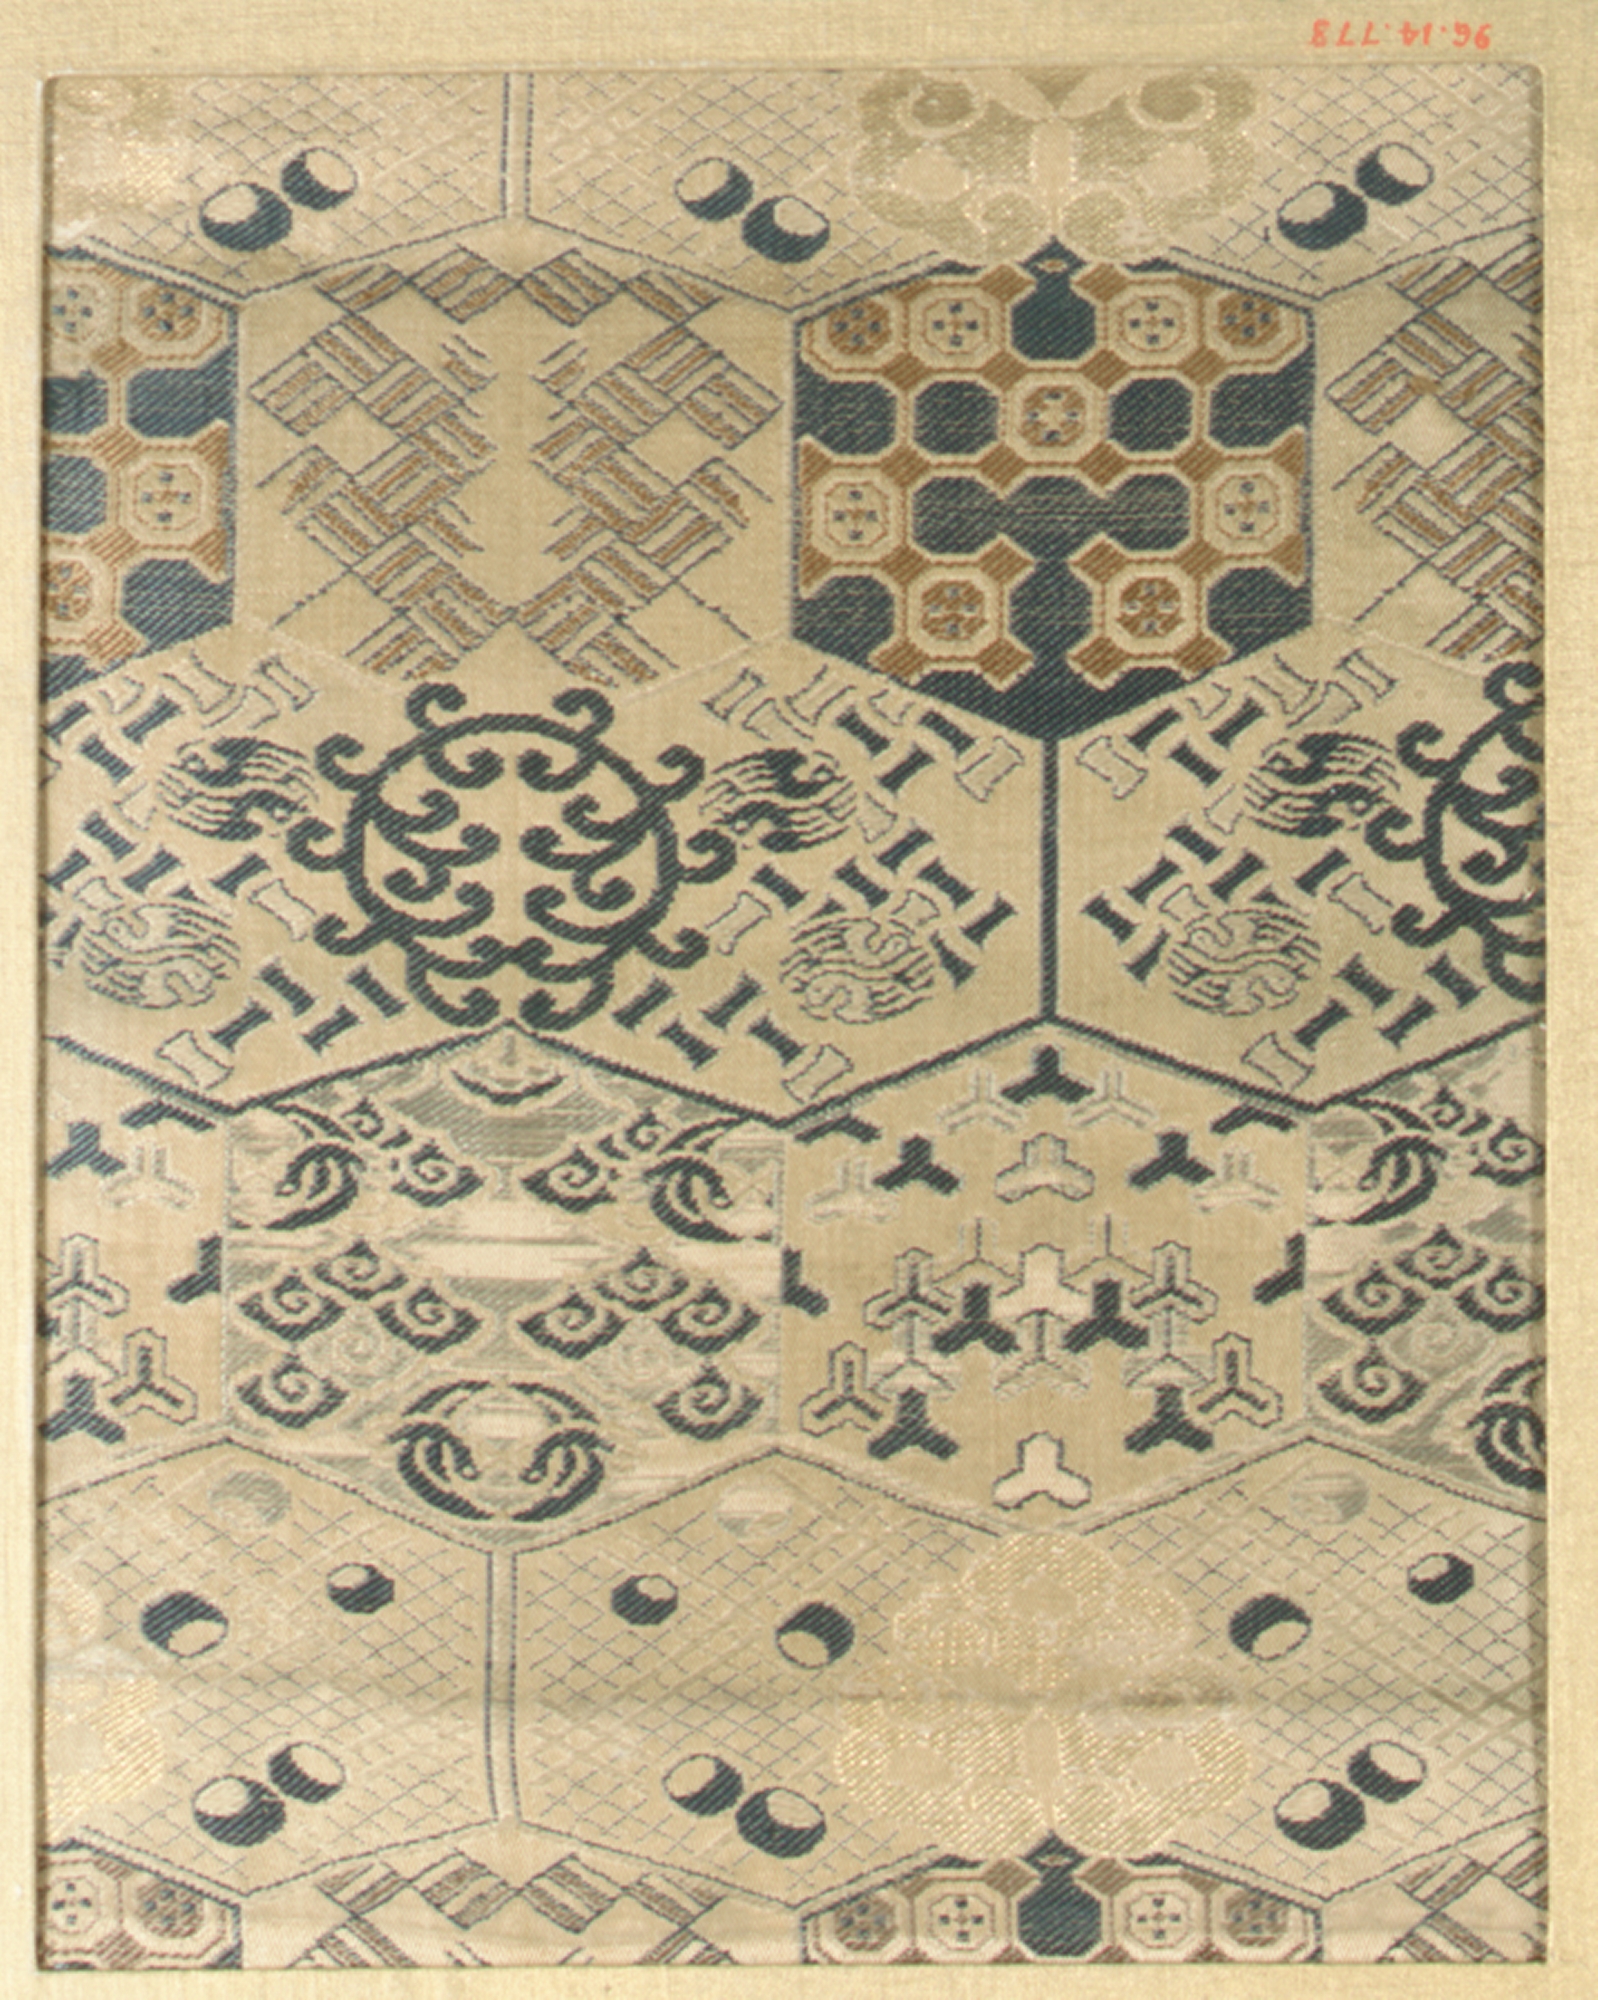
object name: piece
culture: japanese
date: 1701-1900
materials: silk